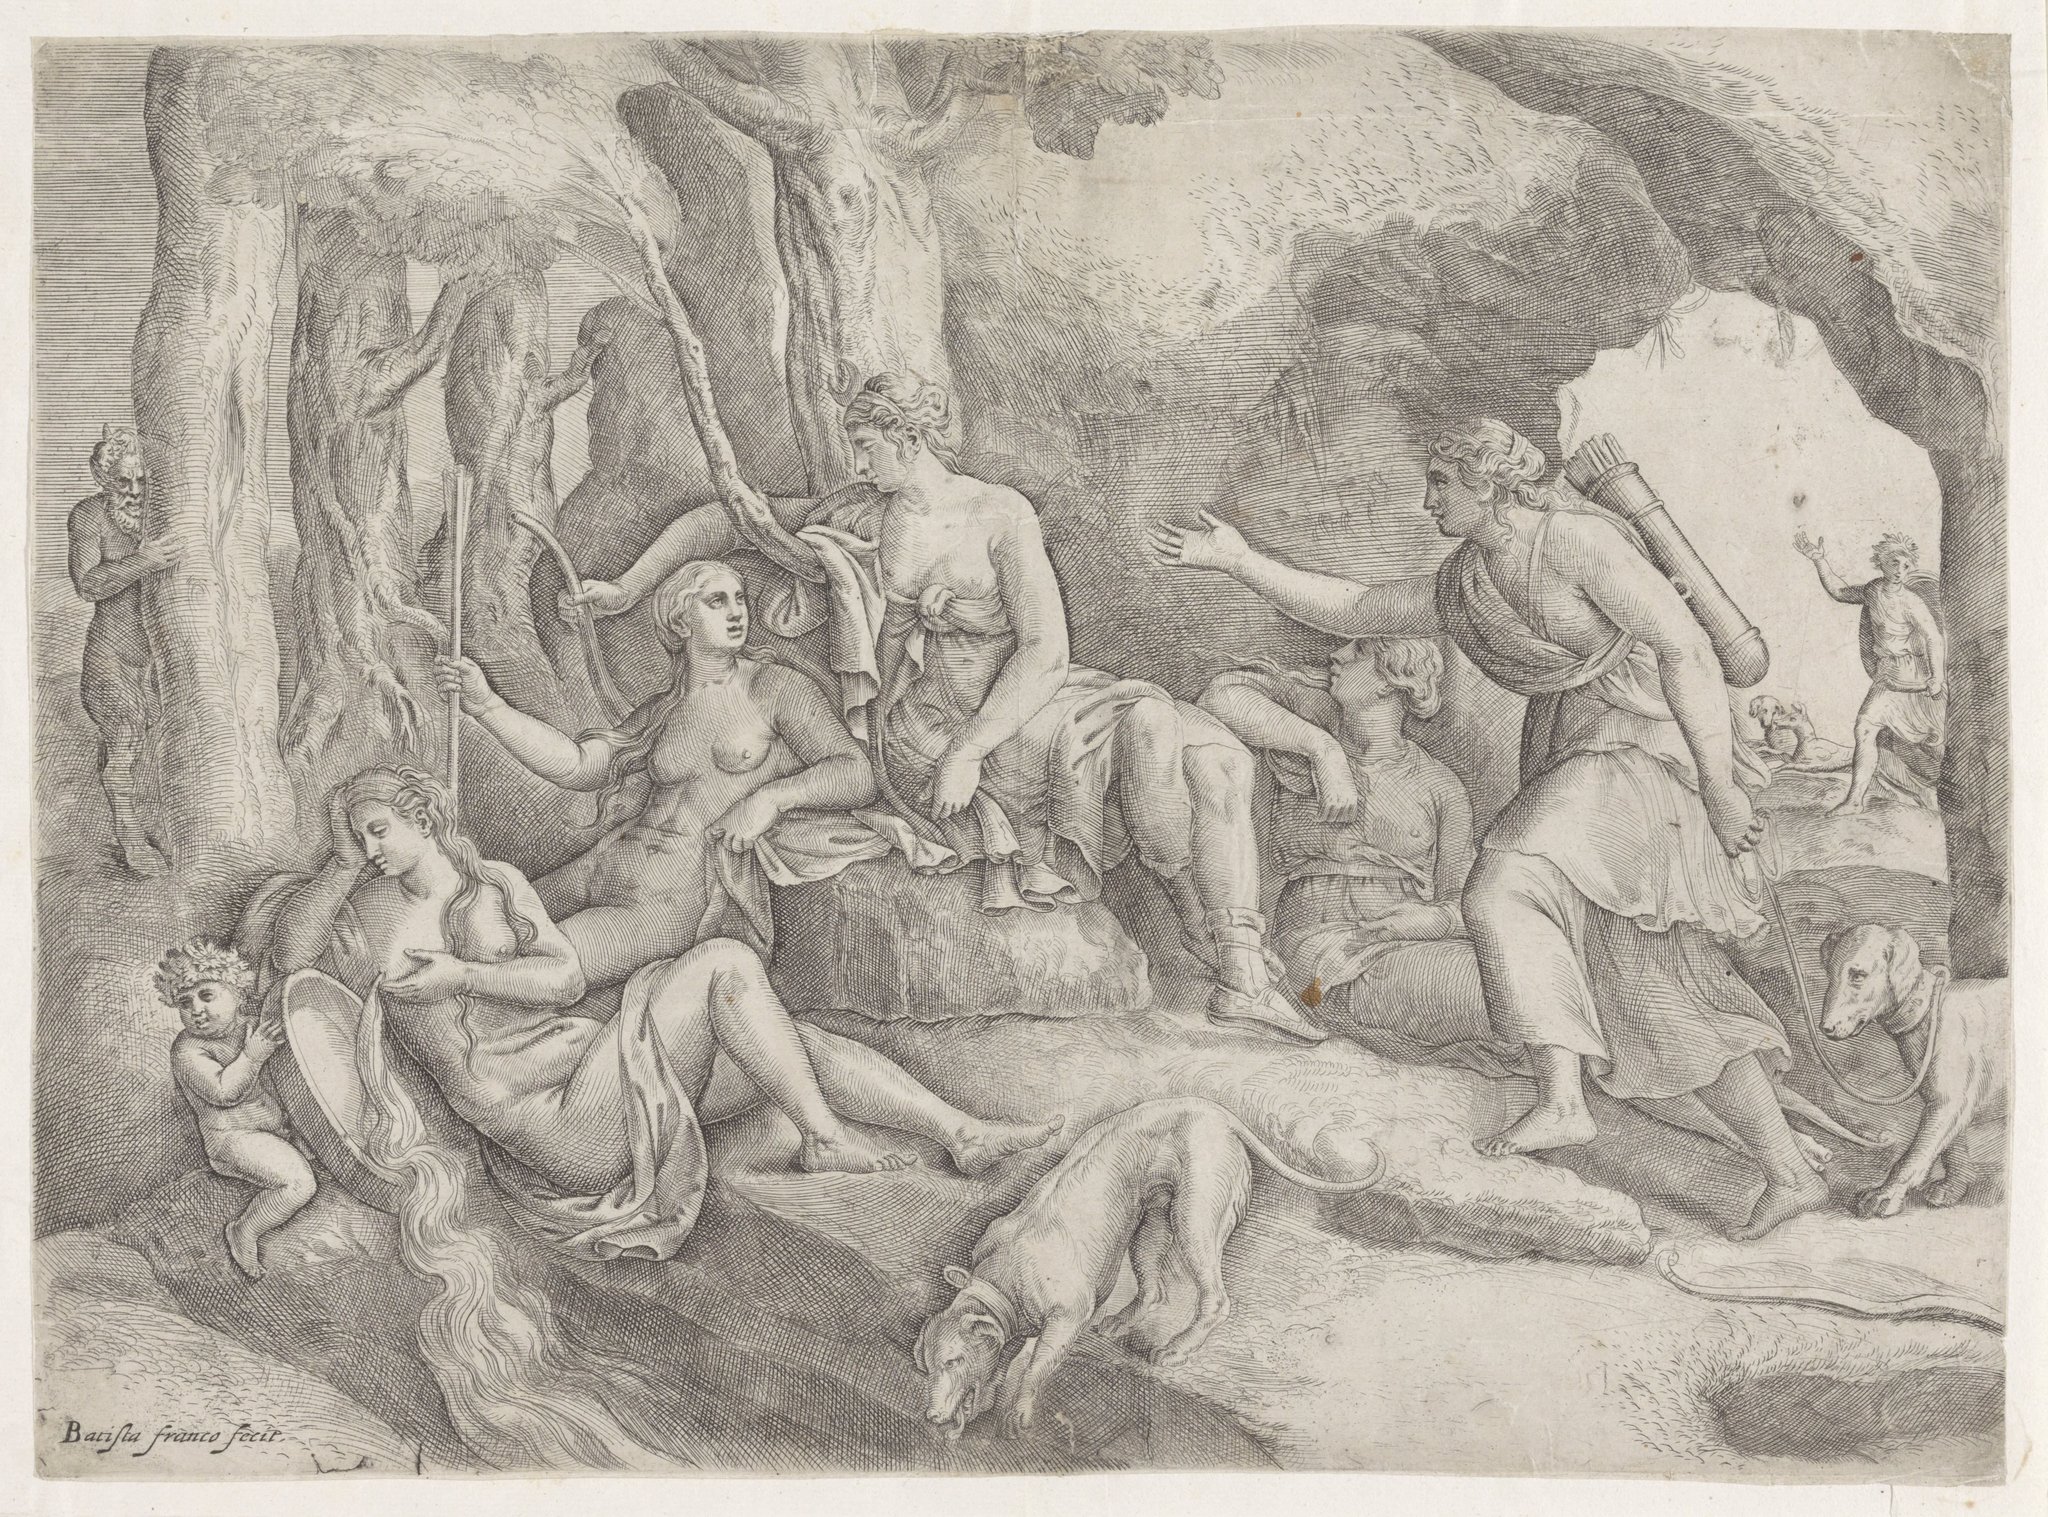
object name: print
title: Diana en haar nimfen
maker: battista franco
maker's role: draughtsman, painter, print maker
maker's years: 1510-1561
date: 1520-1561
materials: paper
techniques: engraving, etching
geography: italy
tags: diana hunting with her nymphs, other companions, nymphs of diana, satyr(s) (in general), adonis hunting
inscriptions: collector's mark: Lugt 2228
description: Diana, zittend op een rots in het midden, rust met haar nimfen tussen de bomen. Op de achtergrond links een sater die de godin en haar metgezellen bespioneert. Op de achtergrond rechts loopt Adonis met zijn jachthonden.